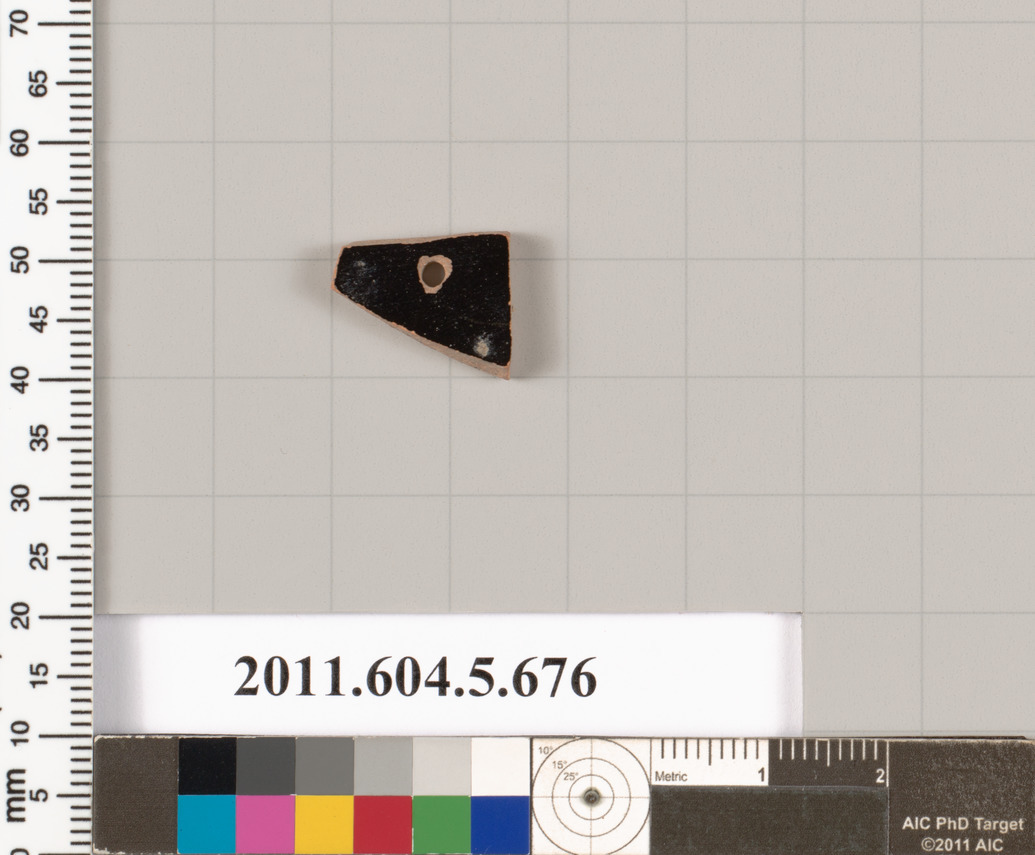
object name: kylix fragment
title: Terracotta fragment of a kylix (drinking cup)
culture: greek, attic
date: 600-401 BCE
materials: terracotta